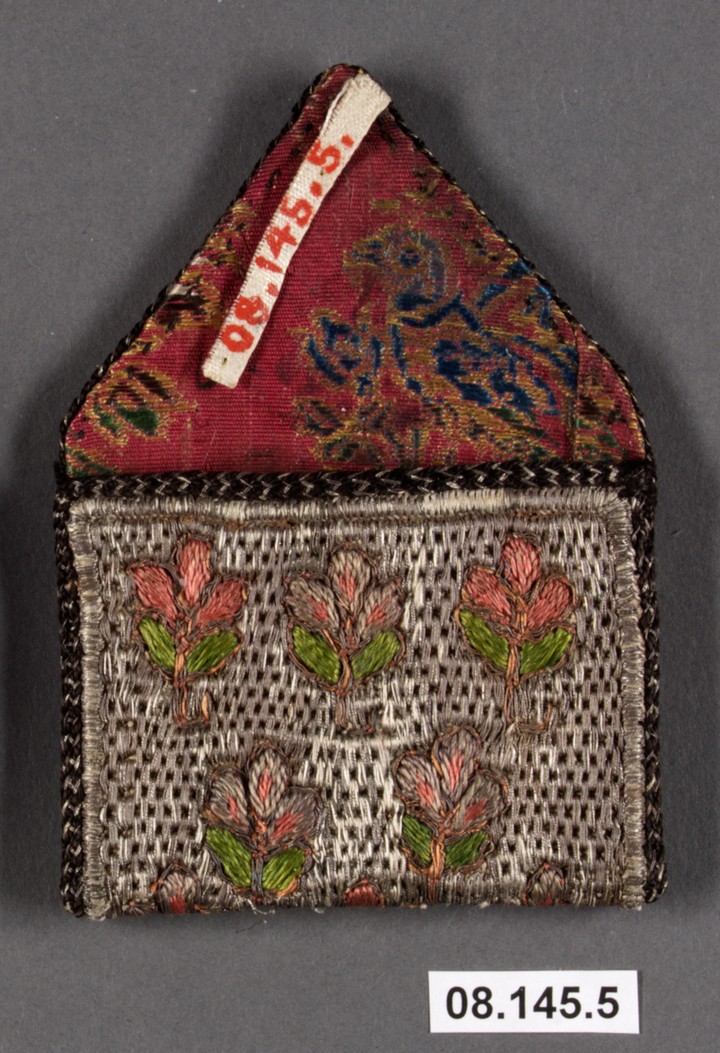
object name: bag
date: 1601-1700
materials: metal thread, silk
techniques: embroidery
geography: iran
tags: birds,flowers